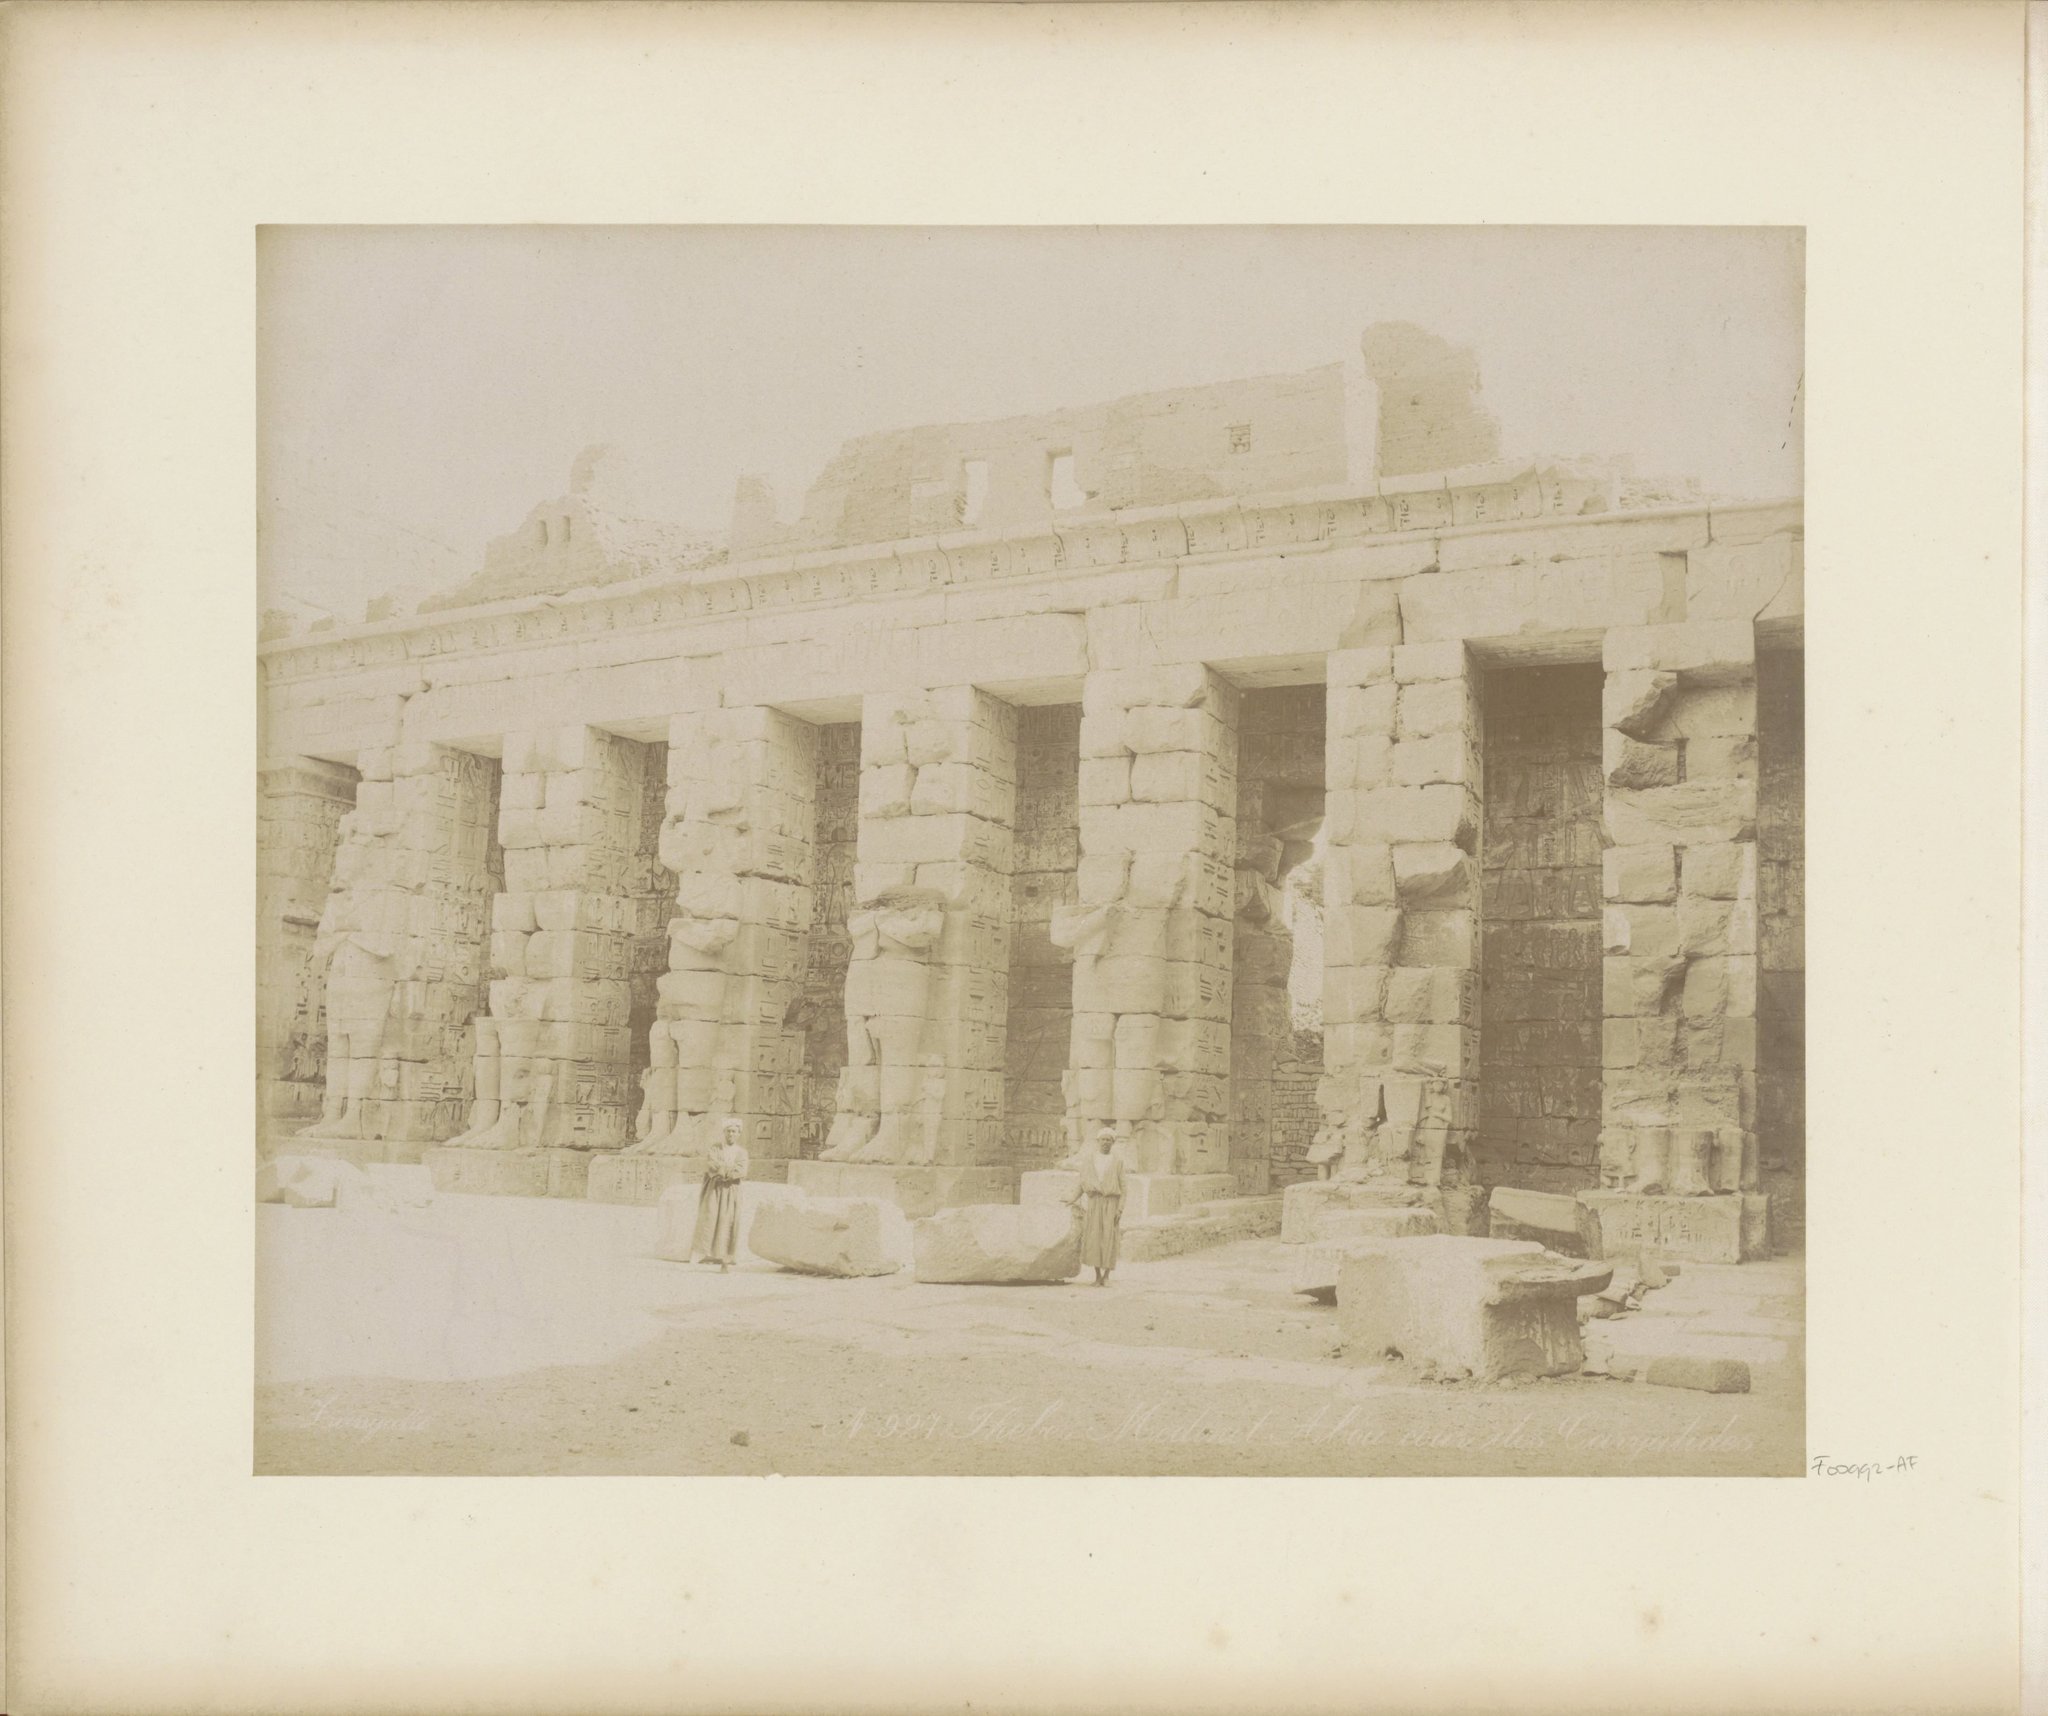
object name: photograph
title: Kariatiden te Medinet-Habou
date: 1870-1890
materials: cardboard, paper, photographic support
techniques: albumen print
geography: medinet habu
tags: caryatids ~ architecture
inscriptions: negative number: ‘927’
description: Onderdeel van Reisalbum met 80 foto's van Egypte.